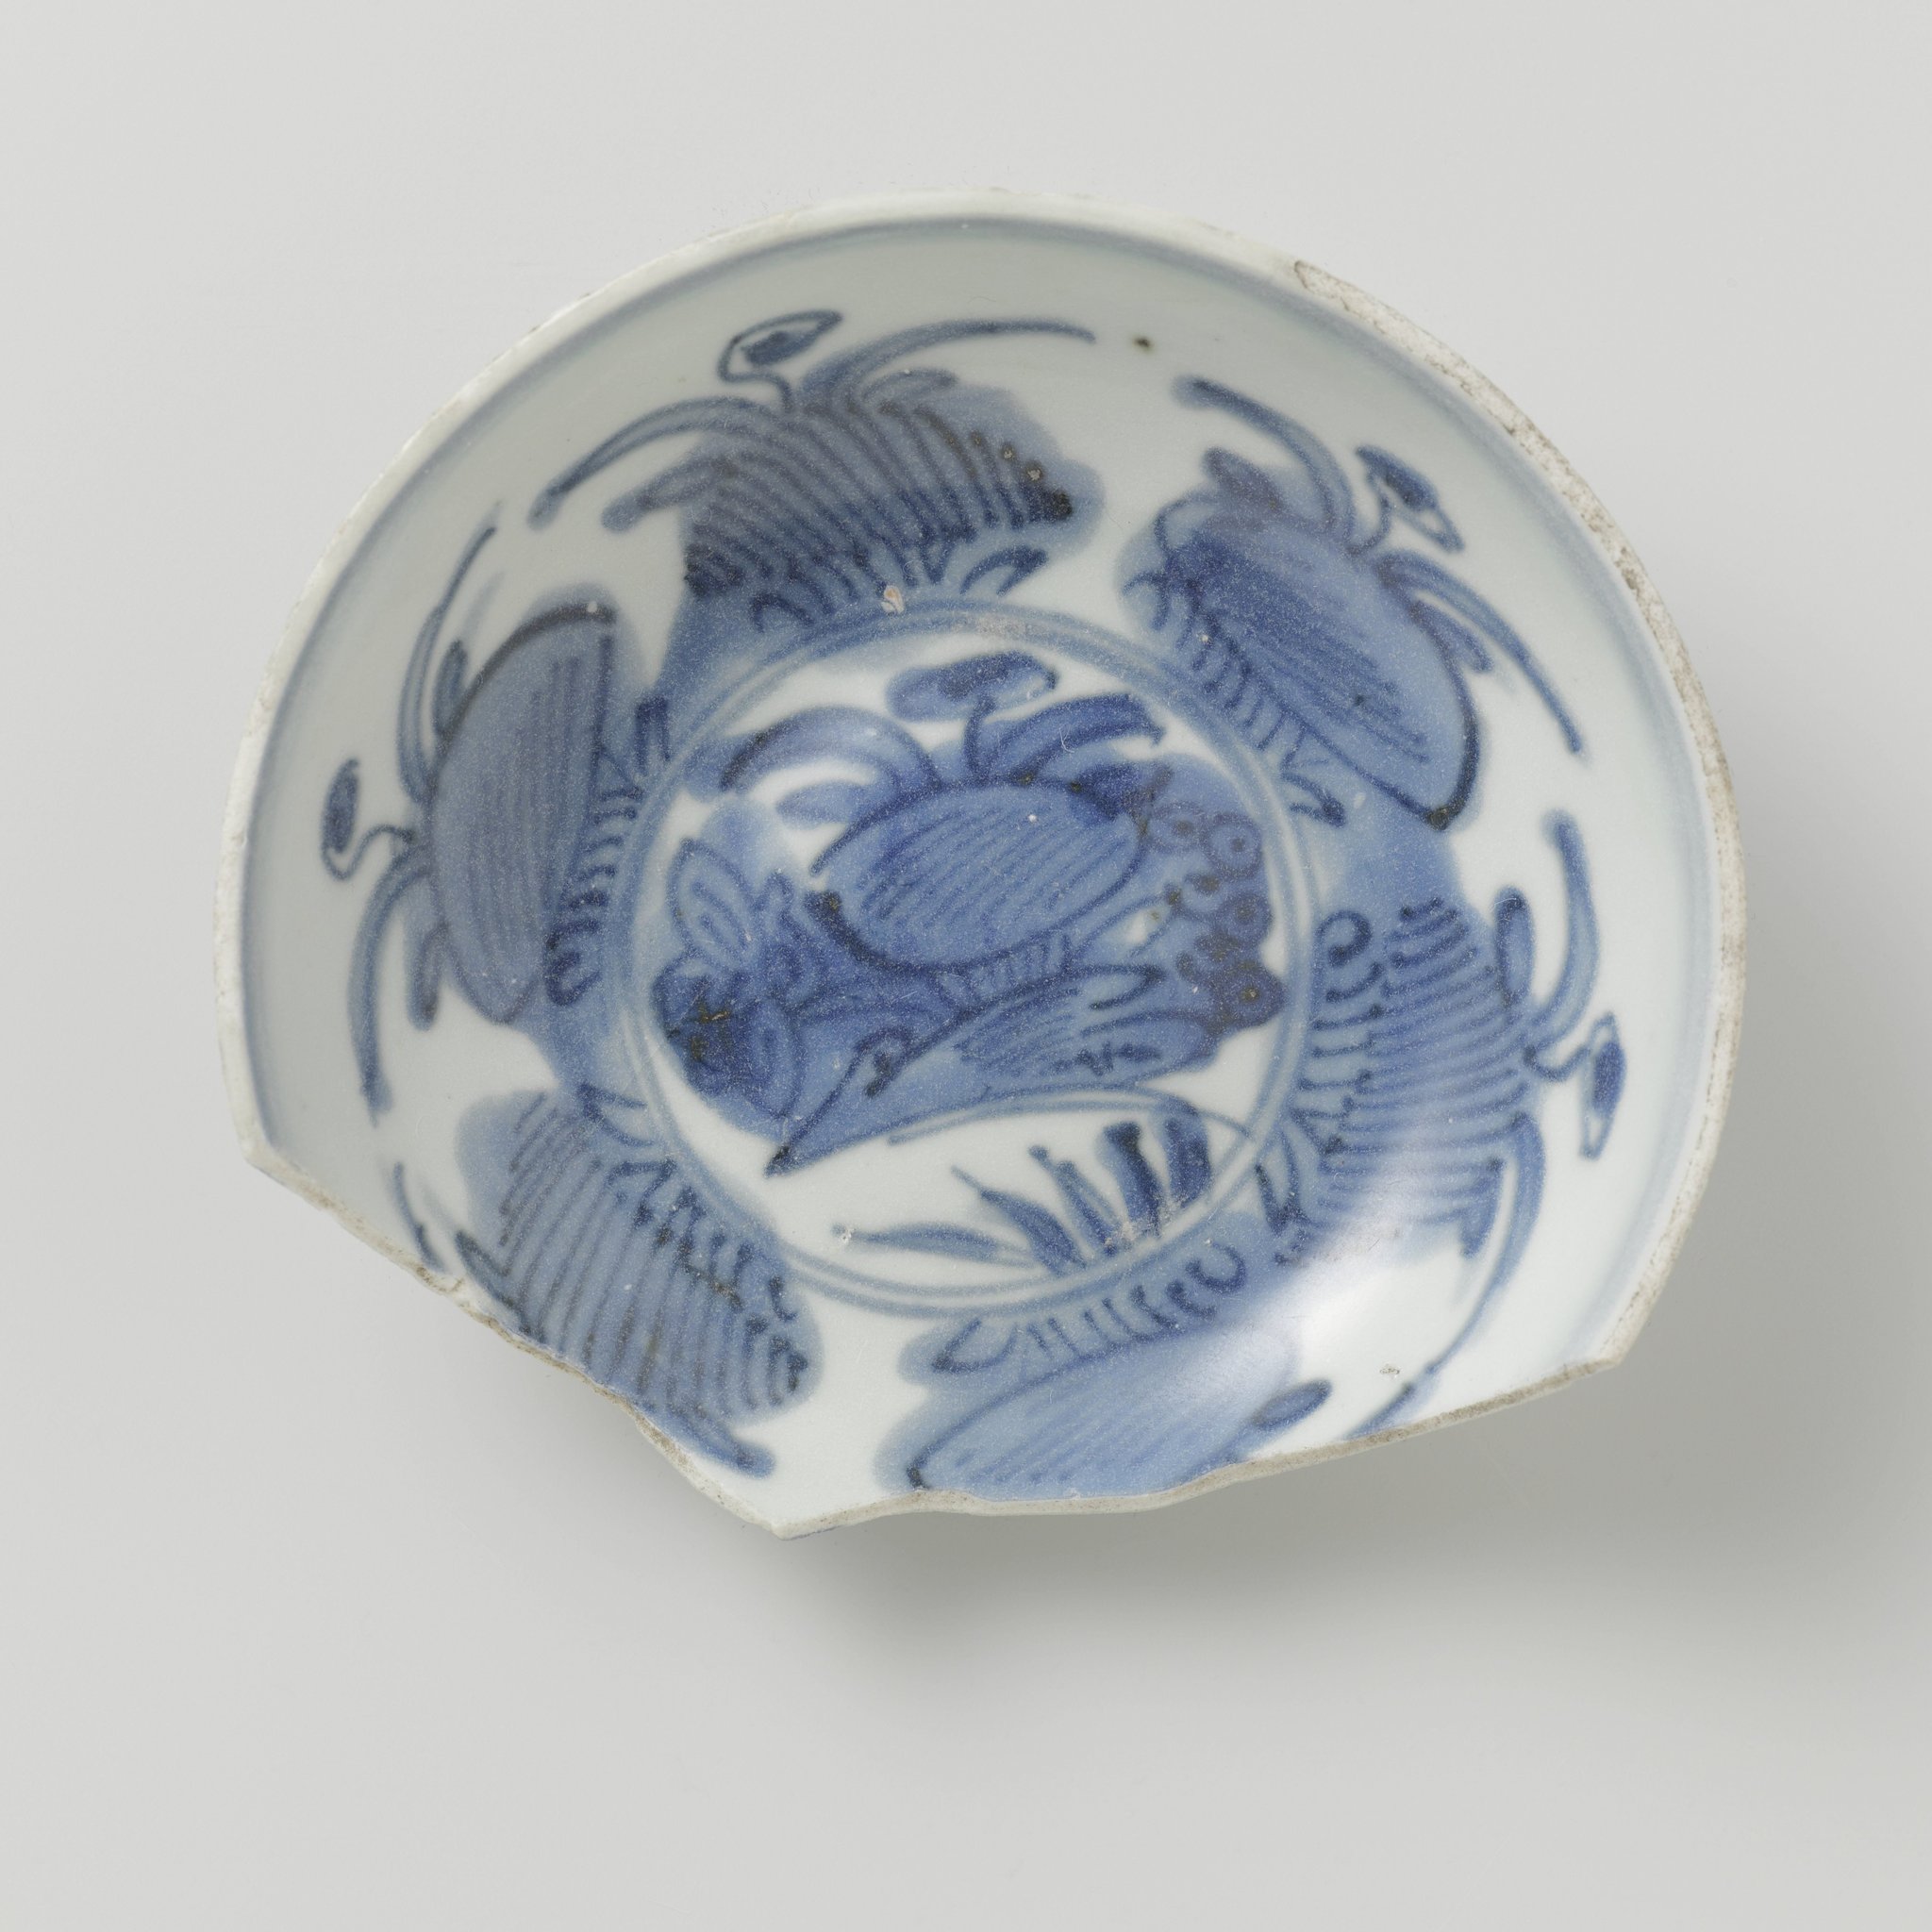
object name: platter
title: Schotel uit V.O.C.-schip de 'Witte Leeuw'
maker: Anonymous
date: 1613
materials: porcelain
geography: jingdezhen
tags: lotus ~ ornament - aa - stylized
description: A saucer. The colour of the cobalt blue varies from grey to purple blue. The decoration on the inside consists of a flowering lotus plant with a duck underneath in the centre. On the cavetto 6 similar lotus plants are drawn.